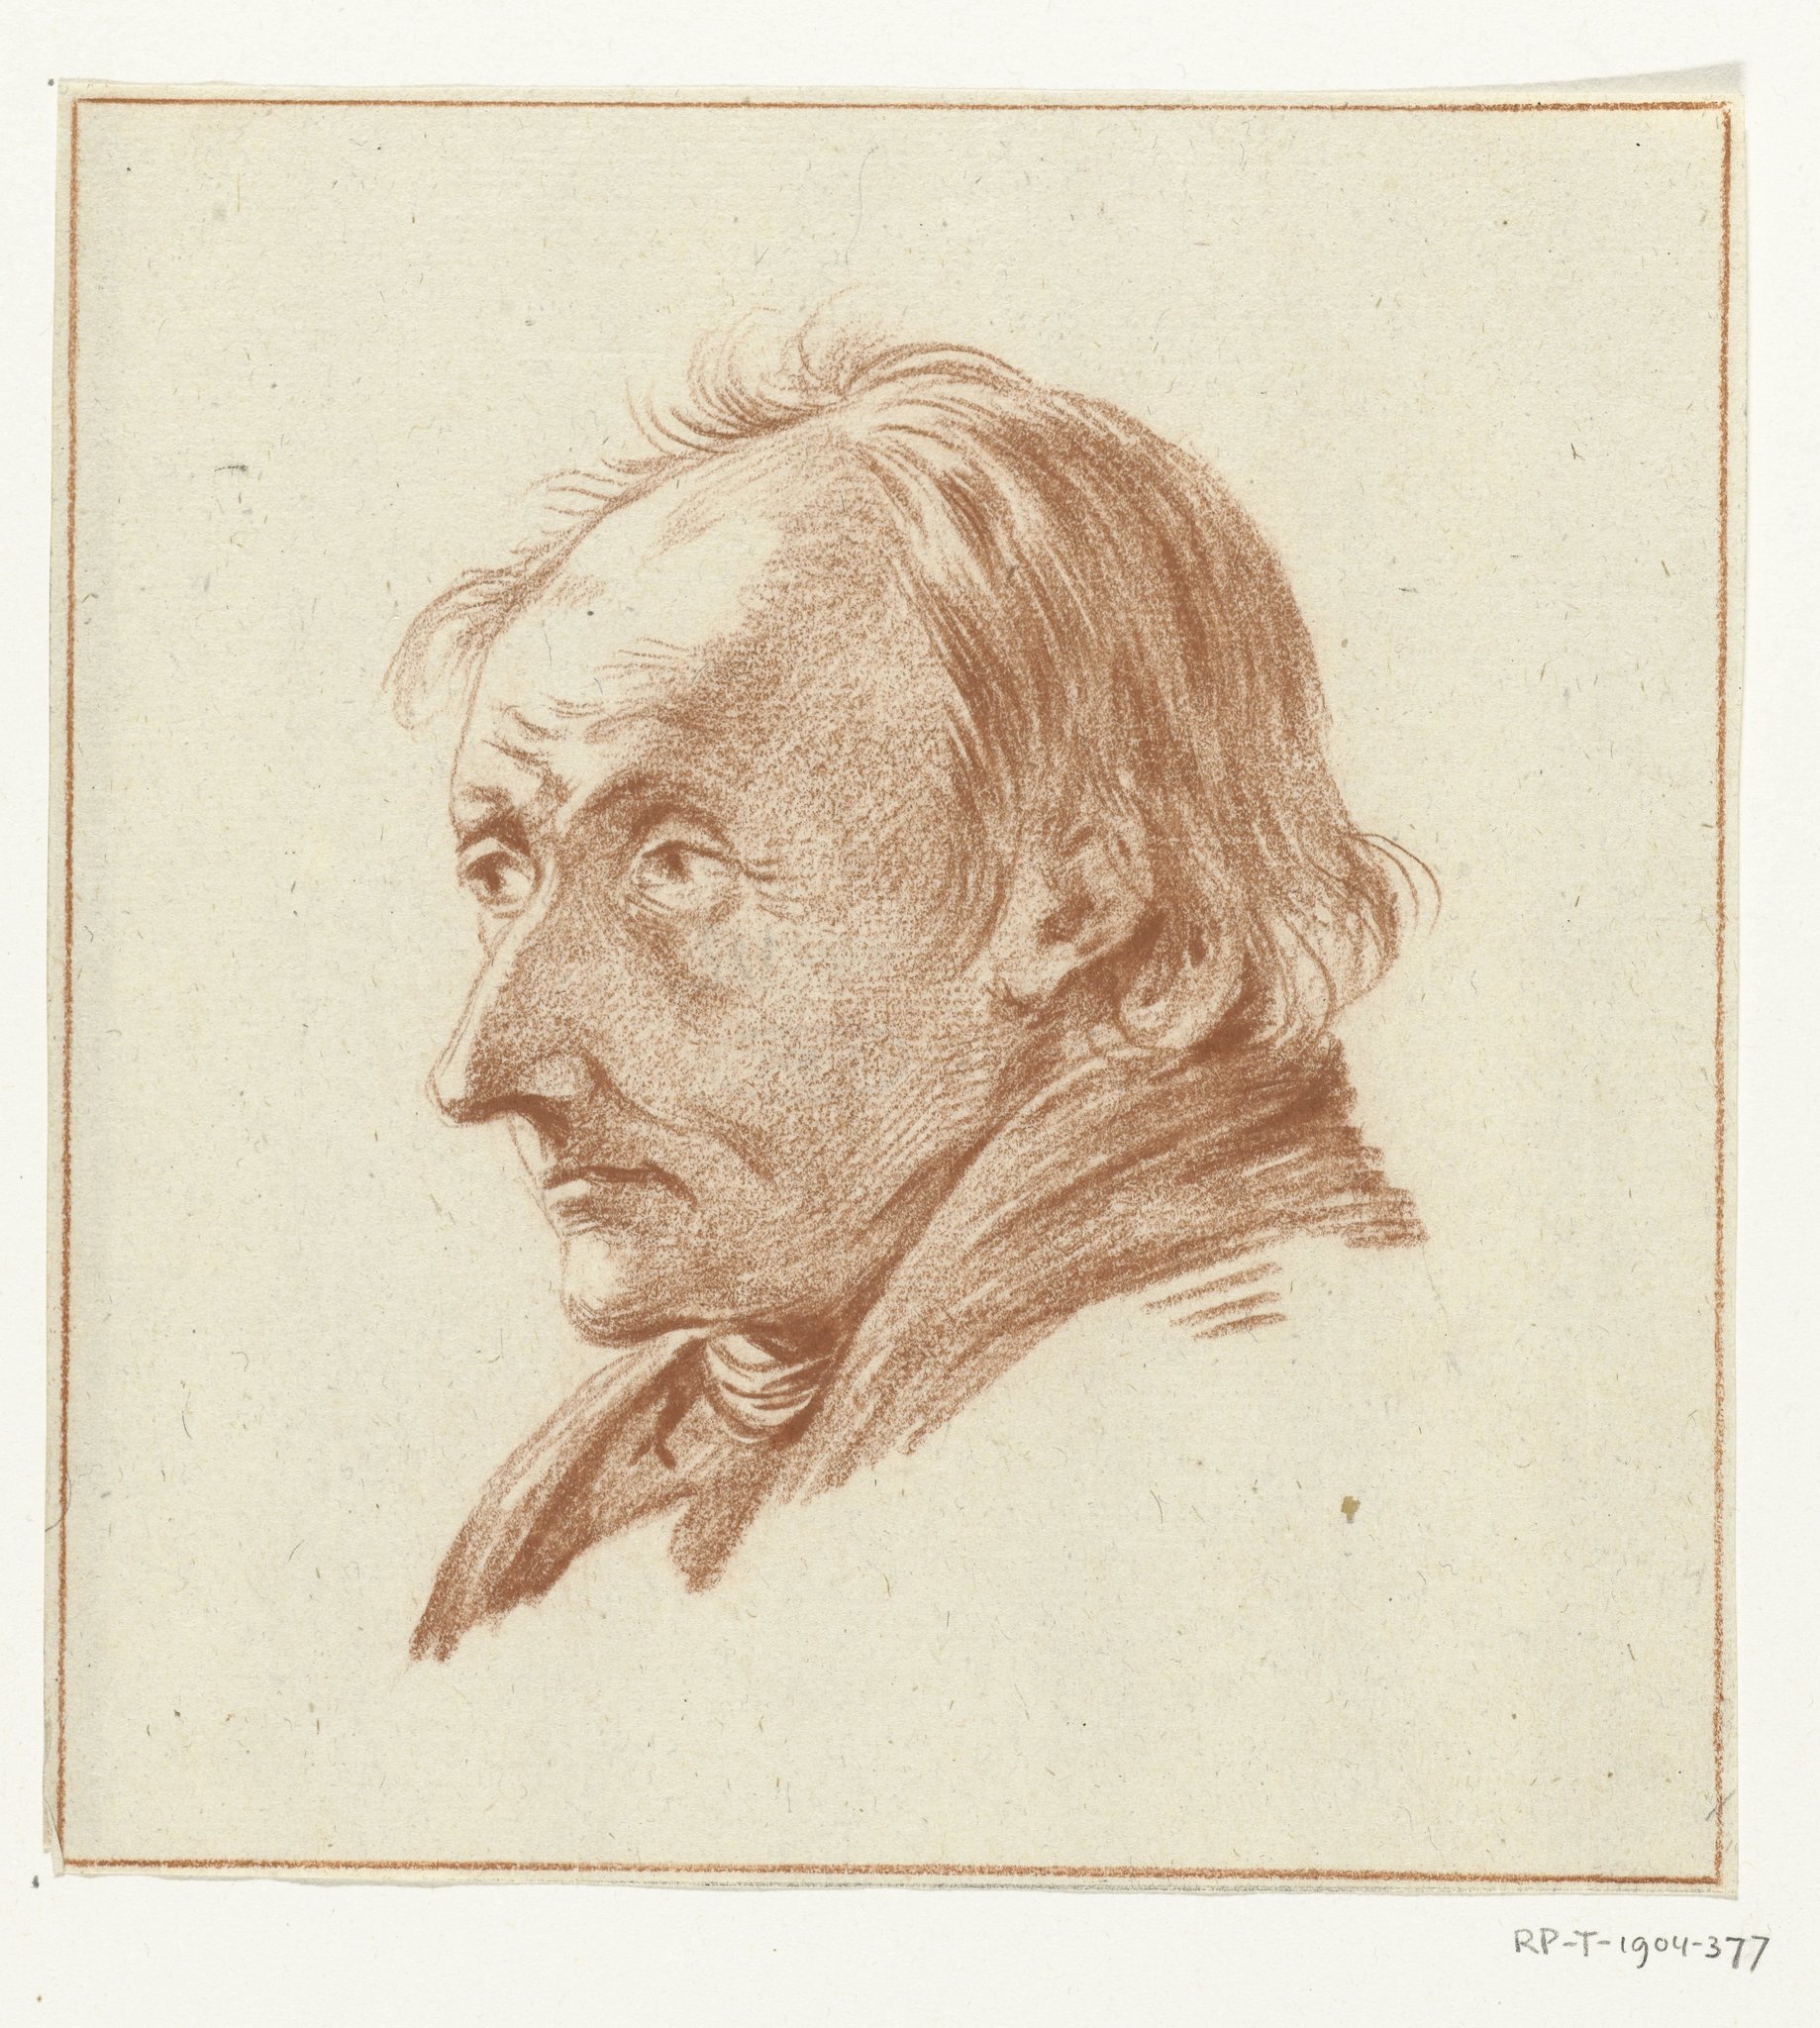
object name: drawing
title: Buste van man, naar links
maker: jean bernard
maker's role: draughtsman, print maker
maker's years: 1765-1833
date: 1775-1833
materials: chalk, paper